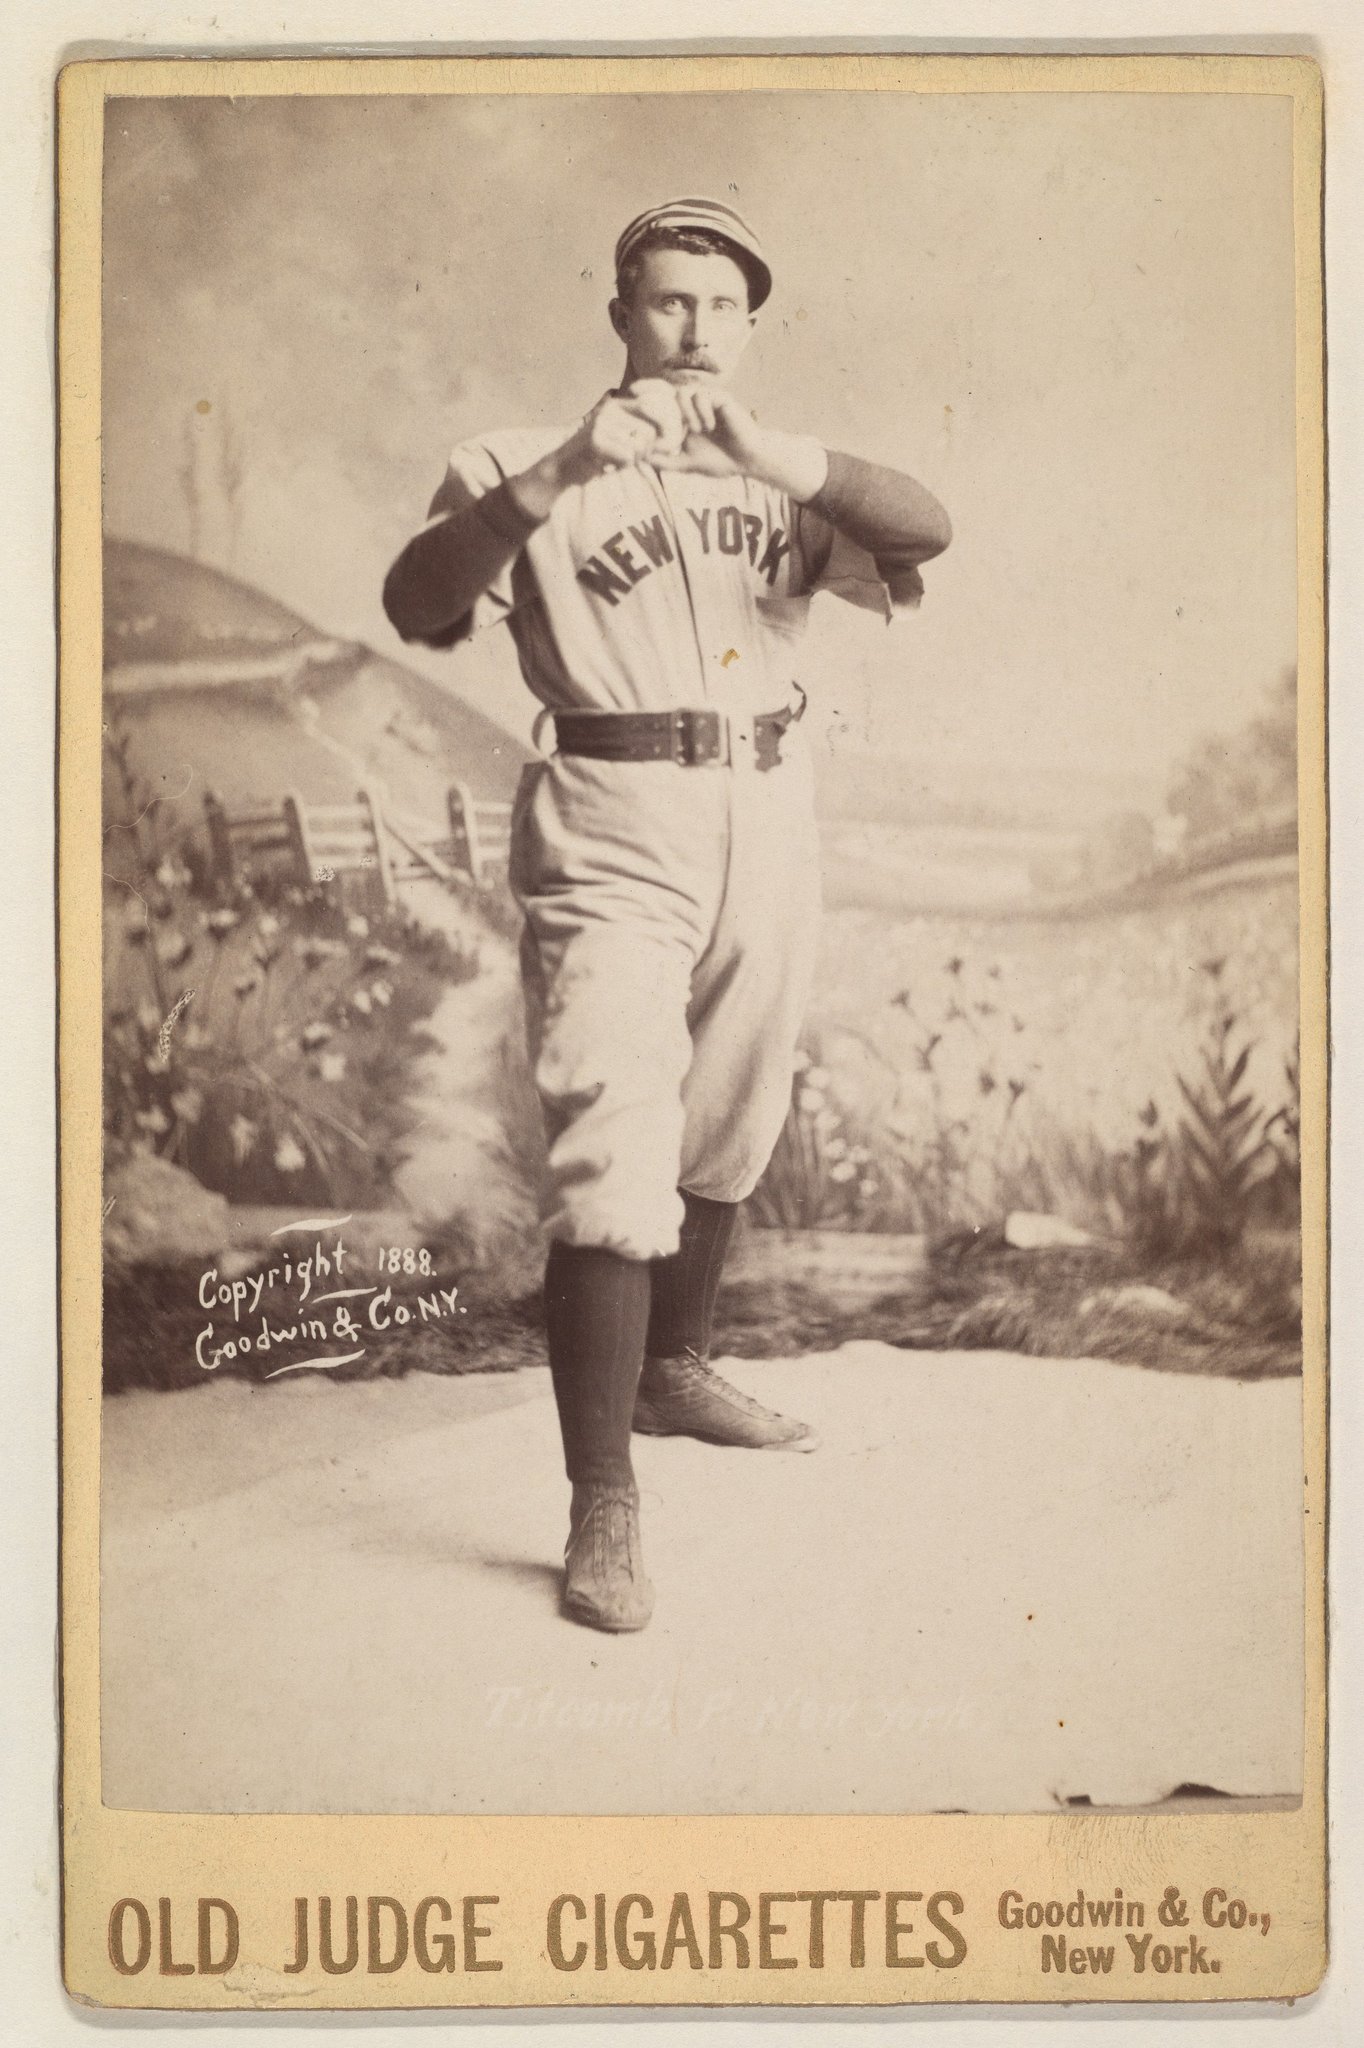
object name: baseball card, photograph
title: Titcomb, Pitcher, New York, from the series Old Judge Cigarettes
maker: goodwin & company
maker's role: publisher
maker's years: 1850-1950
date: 1888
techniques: albumen silver print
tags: men,portraits,baseball,athletes